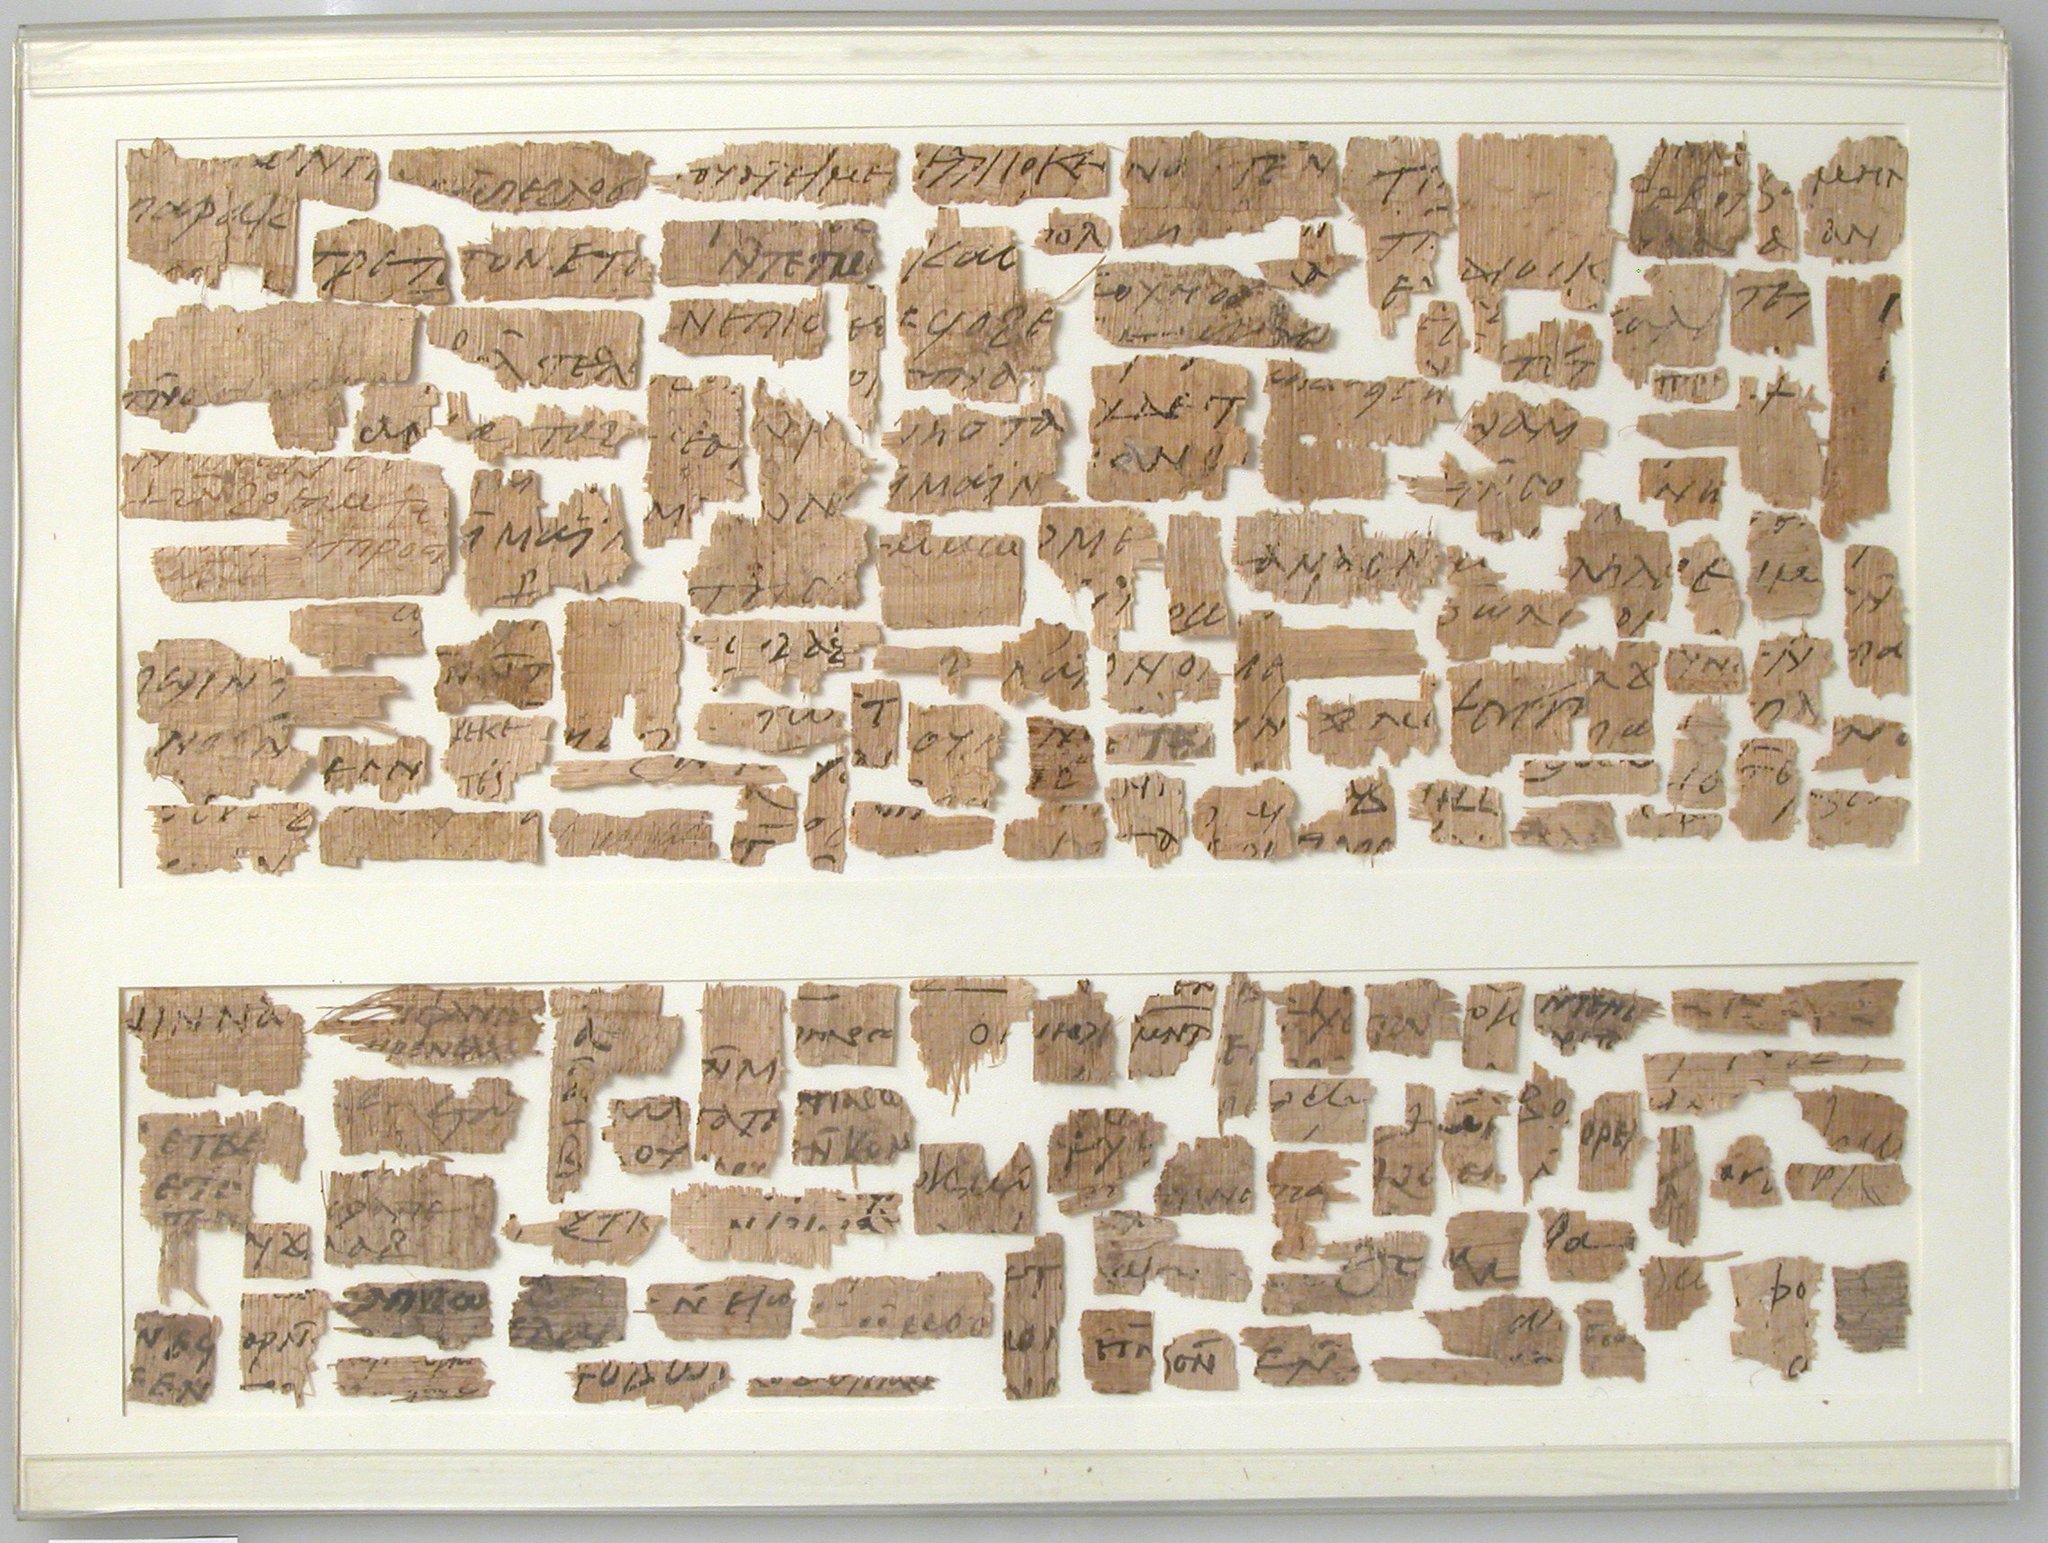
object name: fragment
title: Papyri Fragments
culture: coptic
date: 601-700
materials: ink, papyrus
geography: egypt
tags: documents